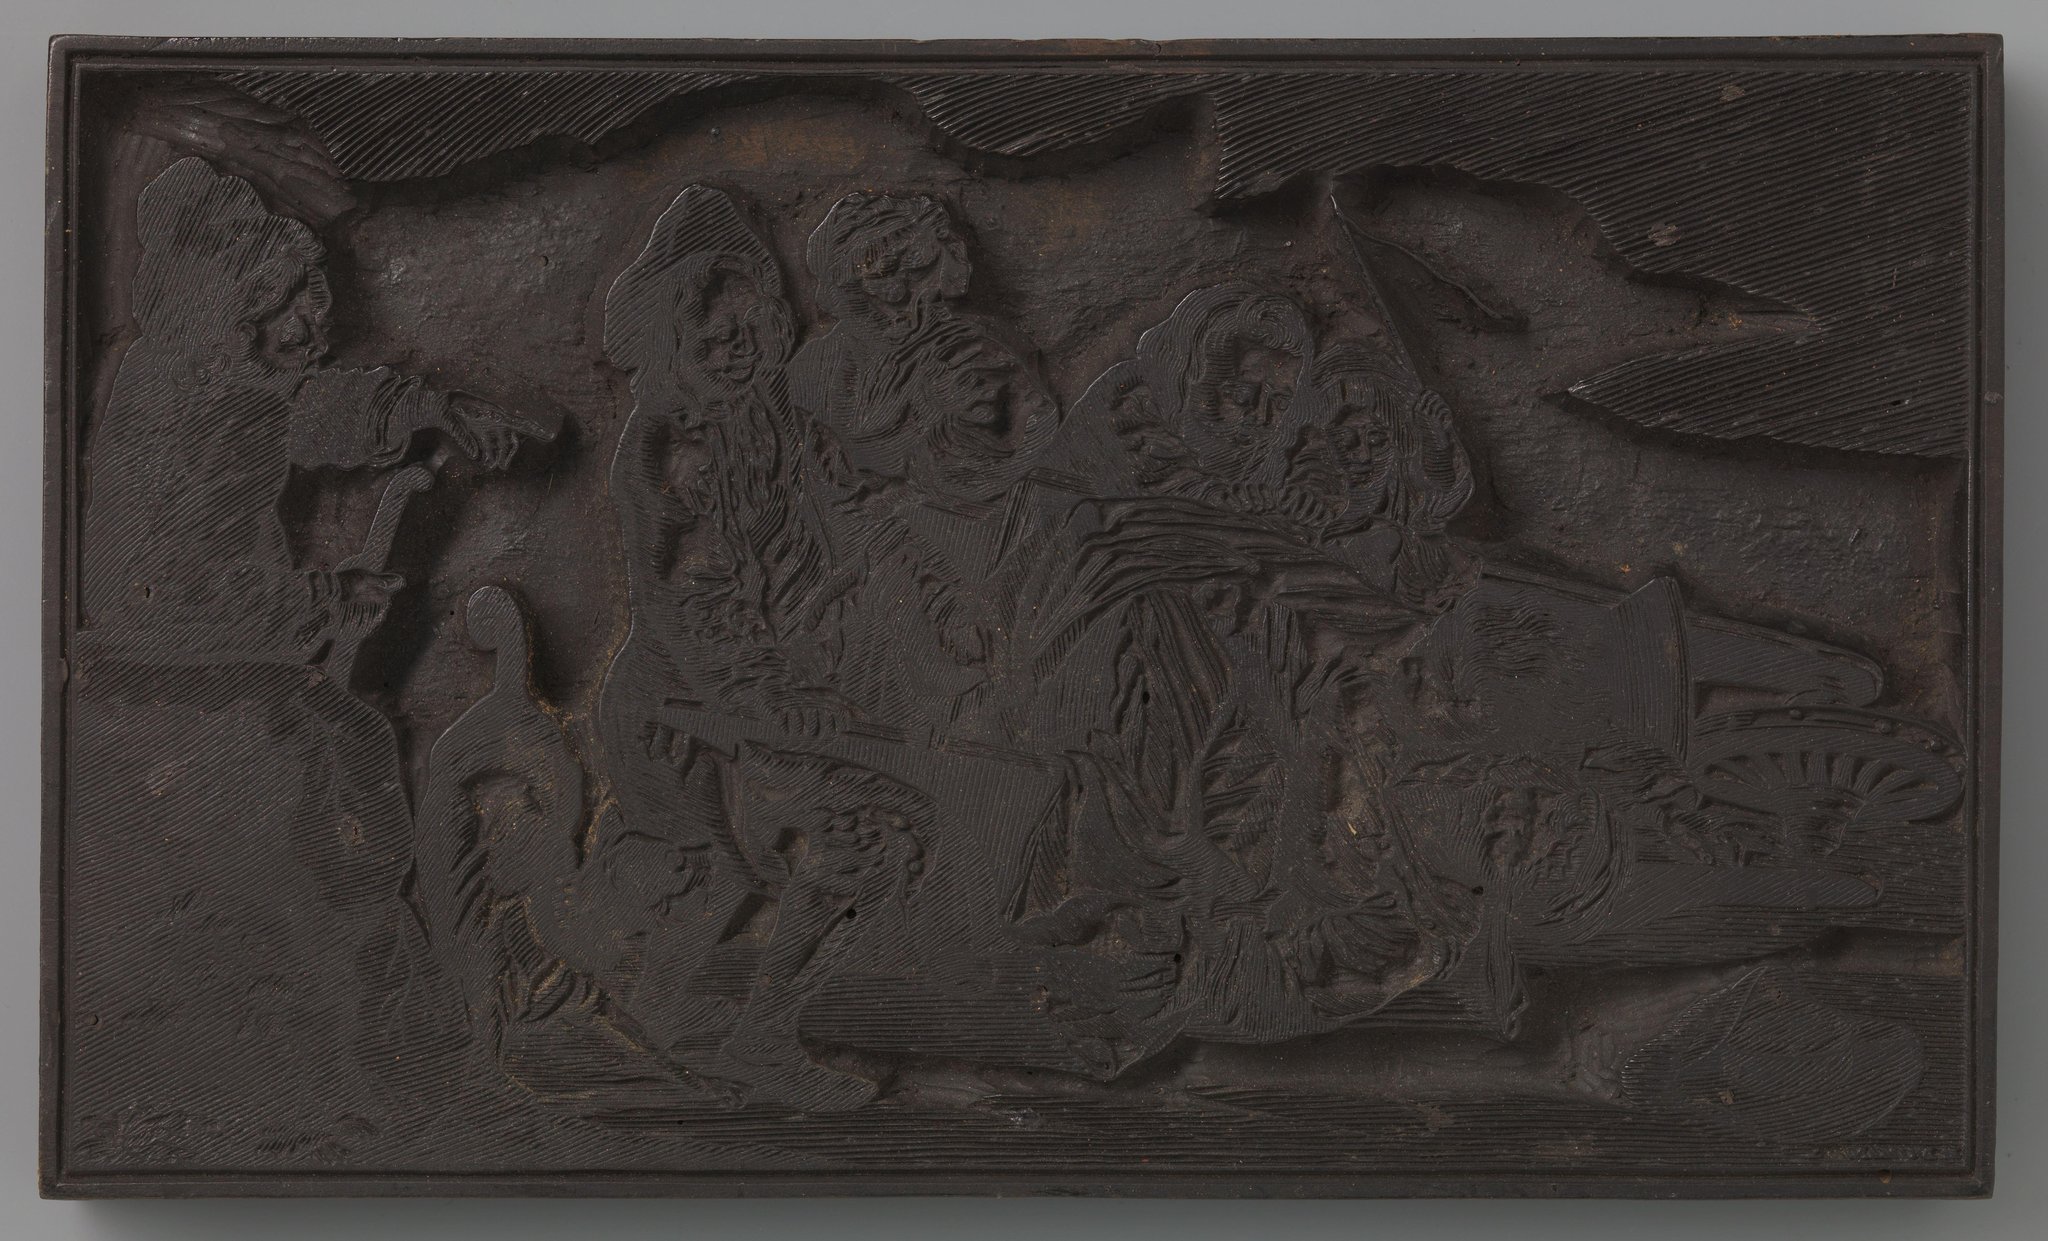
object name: wood block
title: Vier mensen duwen een handkar waarop een lijk ligt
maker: hendrik numan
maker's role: draughtsman, print maker, publisher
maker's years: 1736-1788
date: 1746-1788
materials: wood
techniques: woodcut